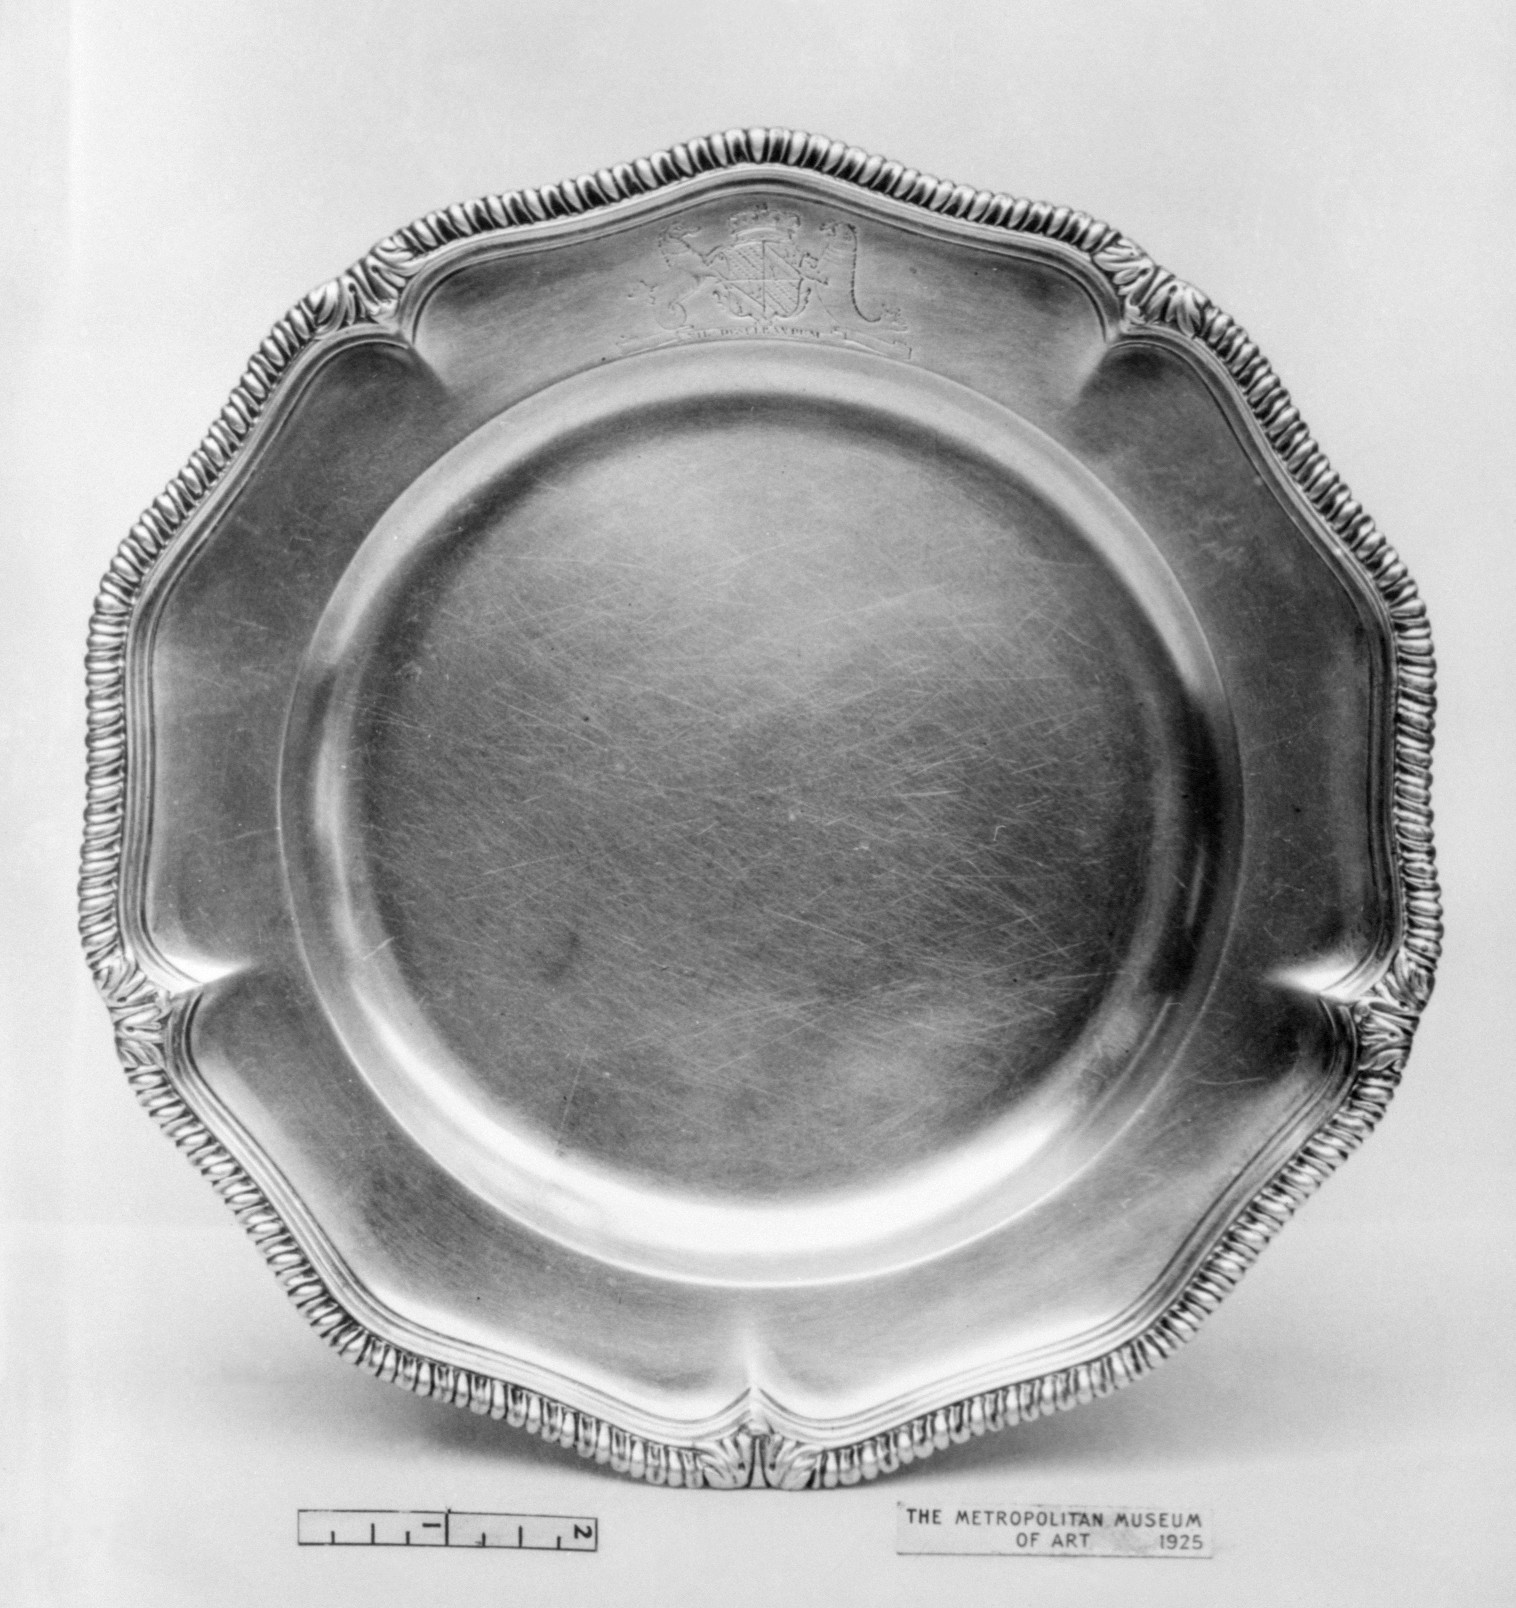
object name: plate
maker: paul de lamerie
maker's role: maker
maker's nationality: british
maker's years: 1688-1751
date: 1746-1747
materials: silver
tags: coat of arms